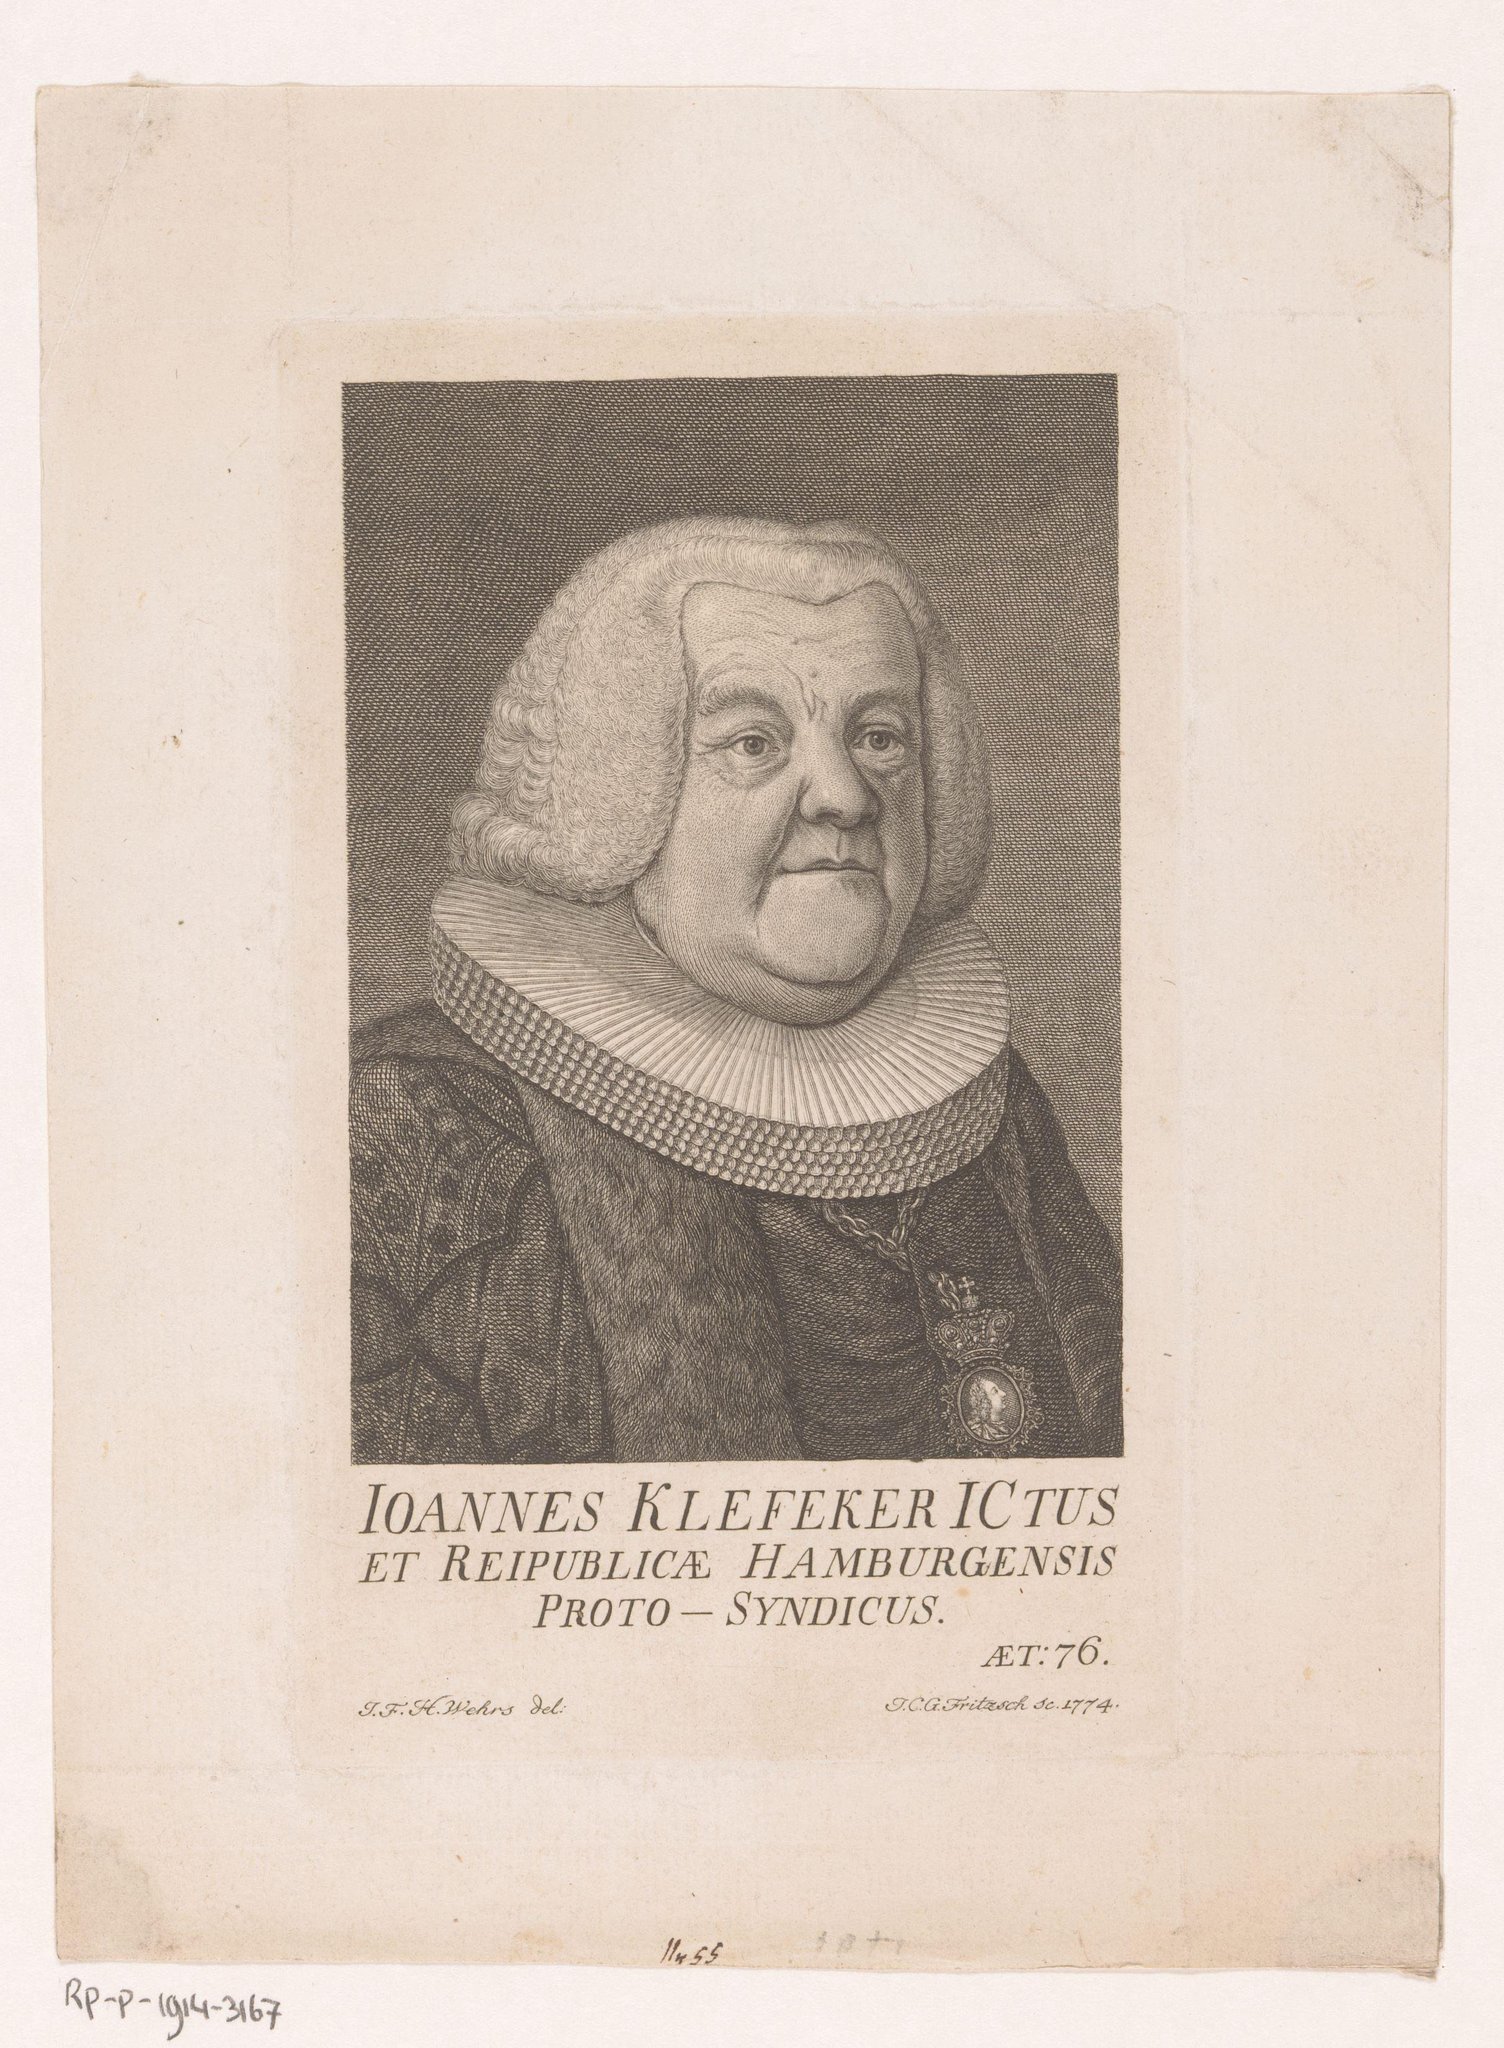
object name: print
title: Portret van Johann Klefeker op 76-jarige leeftijd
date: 1774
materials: paper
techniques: engraving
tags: historical persons, pendant, trinket, 'breloque'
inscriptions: collector's mark: Lugt 2228